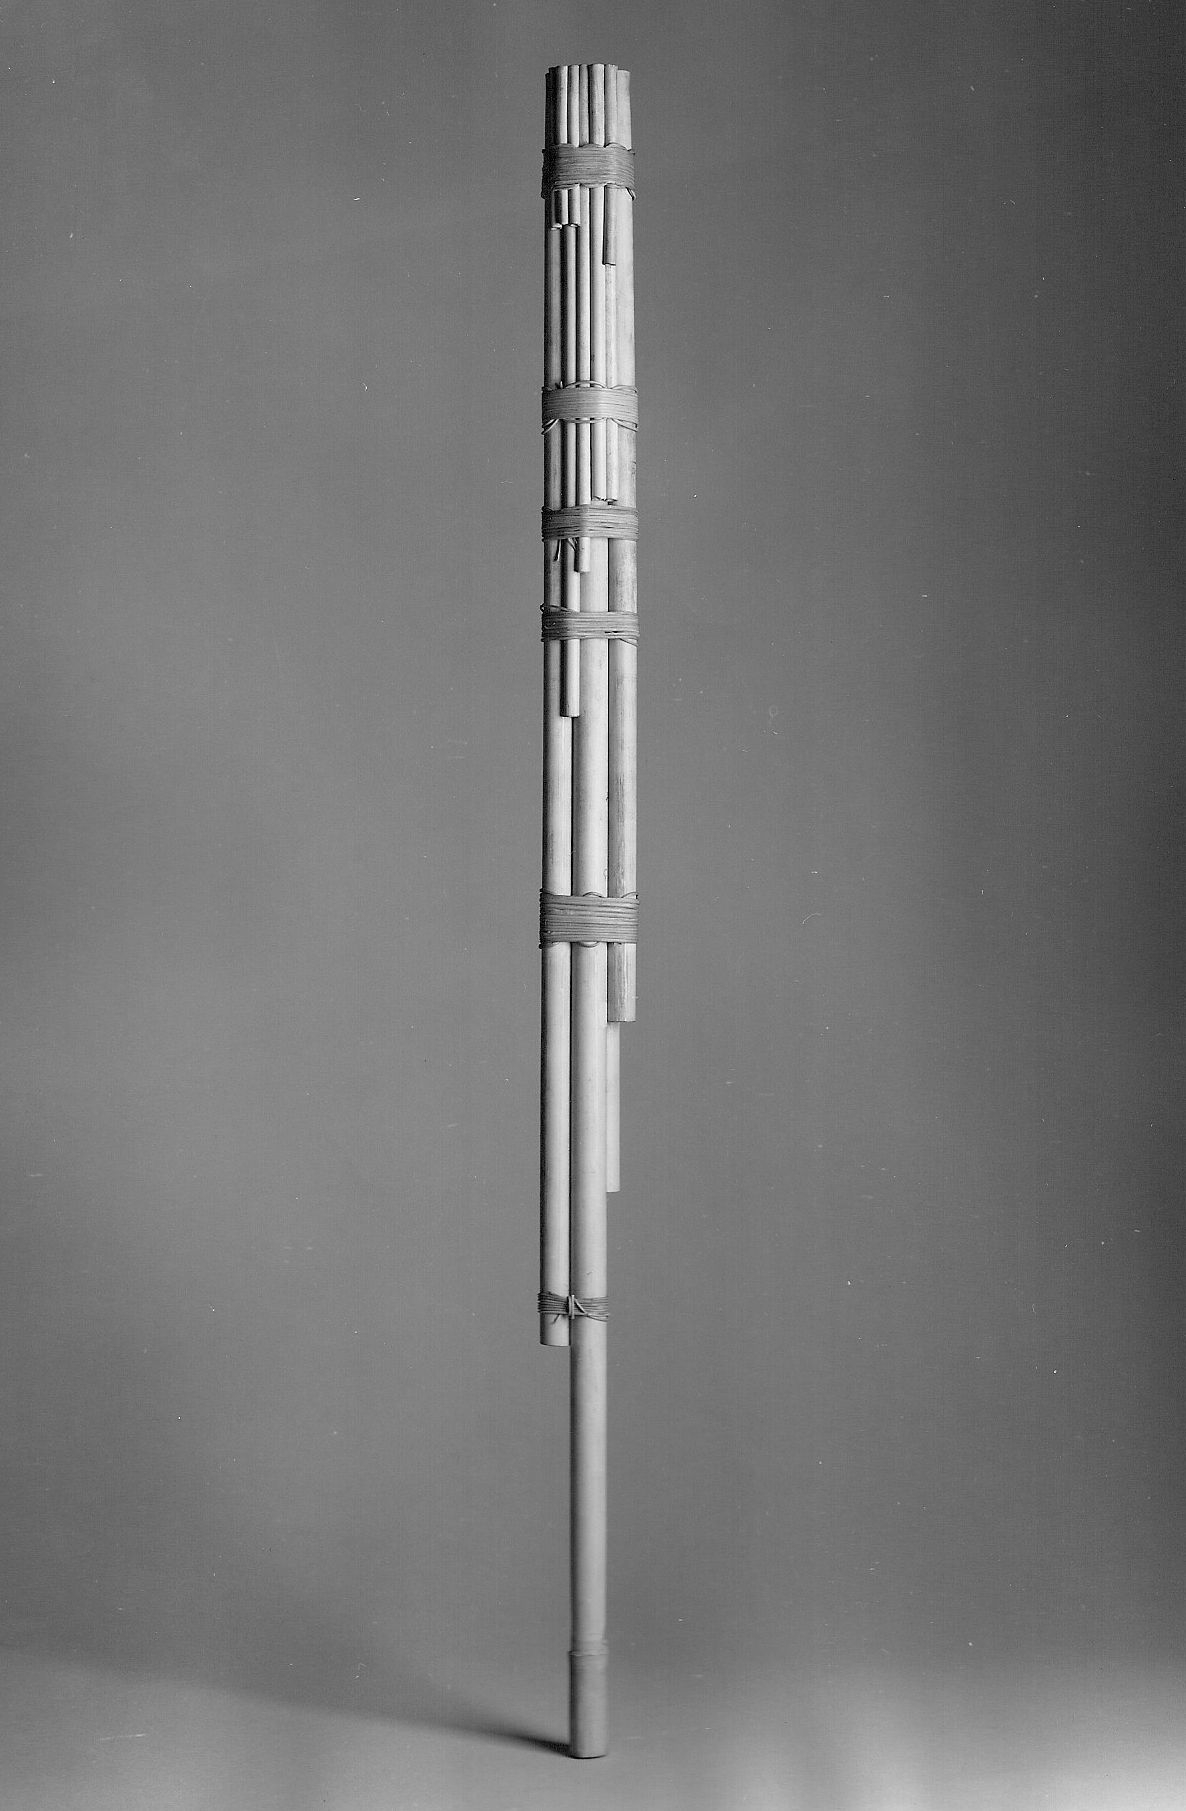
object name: putu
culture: melanesian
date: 1867-1900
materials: bamboo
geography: solomon islands